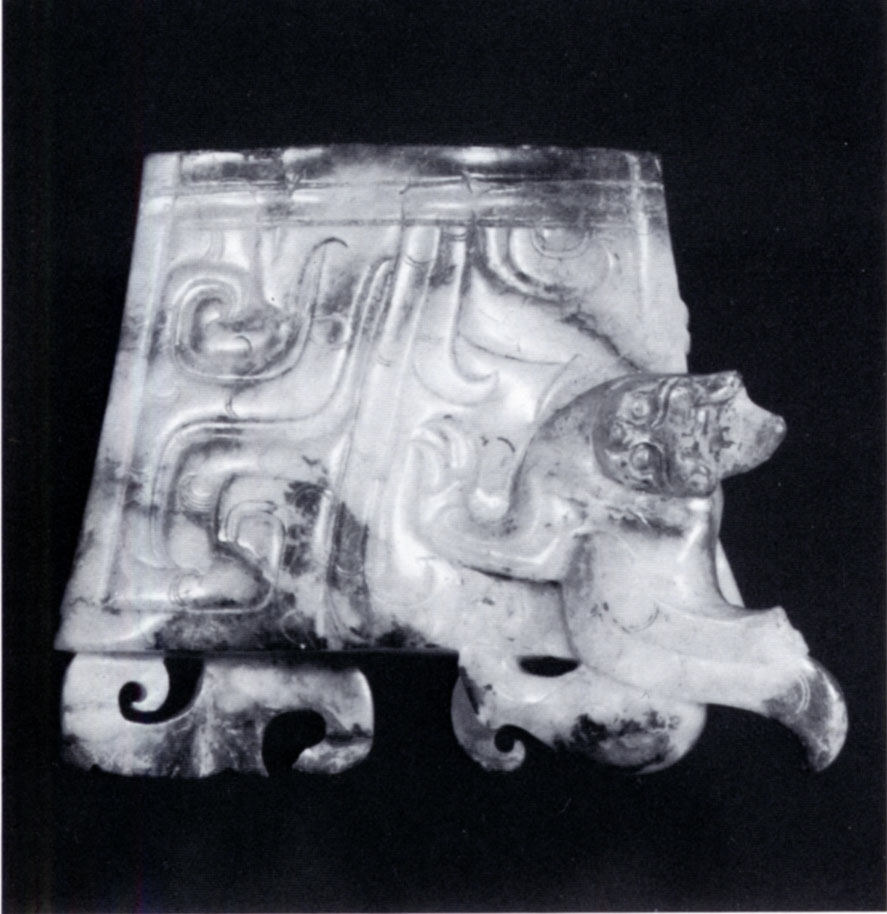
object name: scabbard slide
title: Scabbard Chape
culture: chinese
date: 200-1 BCE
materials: jade